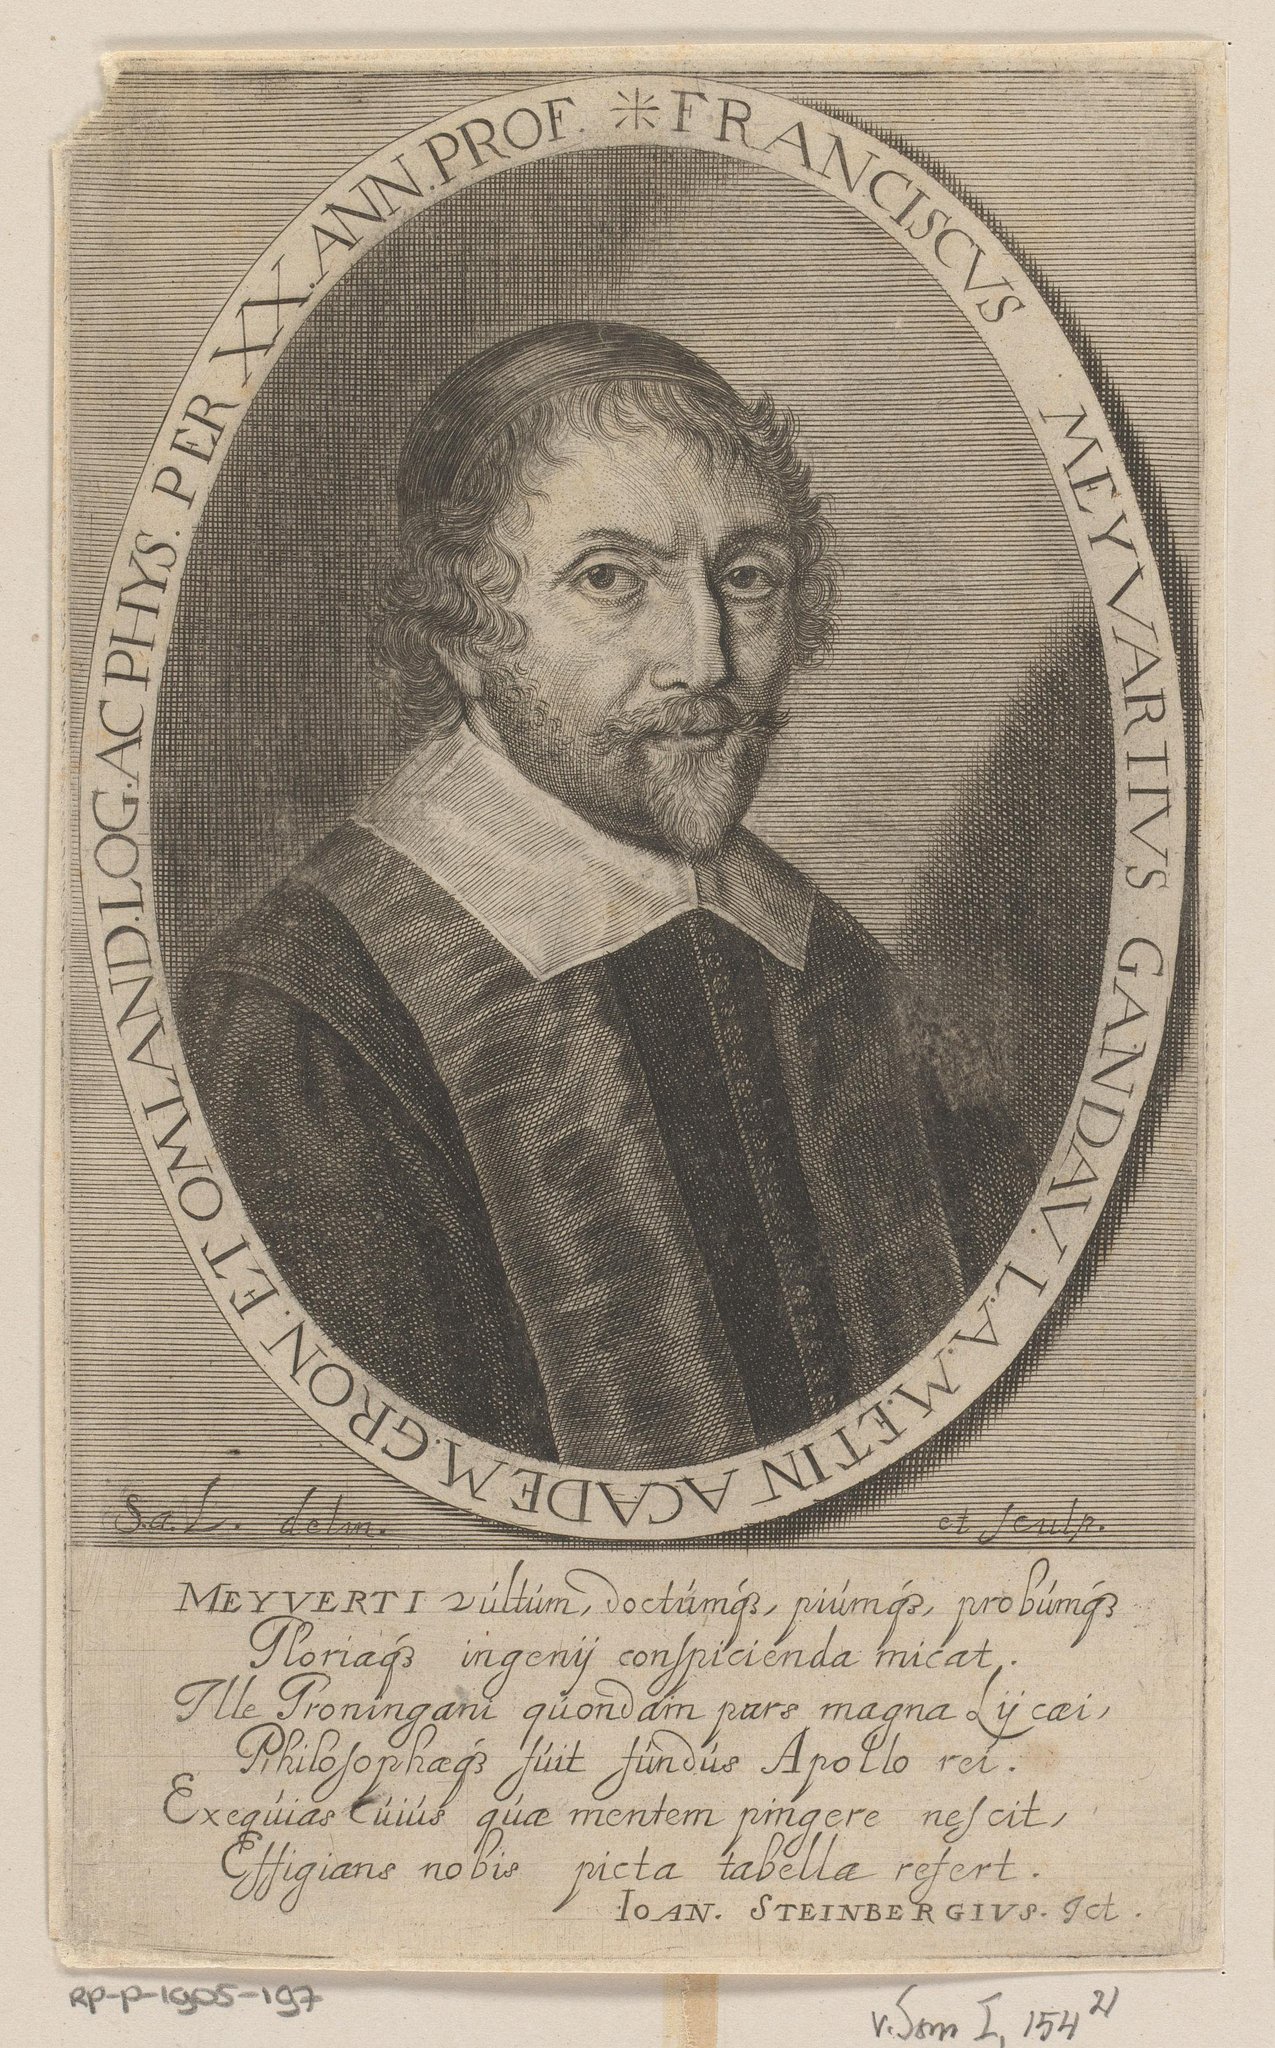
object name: print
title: Meyverti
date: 1654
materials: paper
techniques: engraving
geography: utrecht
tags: historical persons, professor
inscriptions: collector's mark: Lugt 1337, collector's mark: Lugt 2228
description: Portret waarschijnlijk uit: Effigies & vitae Professorvm Academiae Groningae & Omlandiae. Groningen: Hindrick Lussinck en Jan Claessen, 1654.